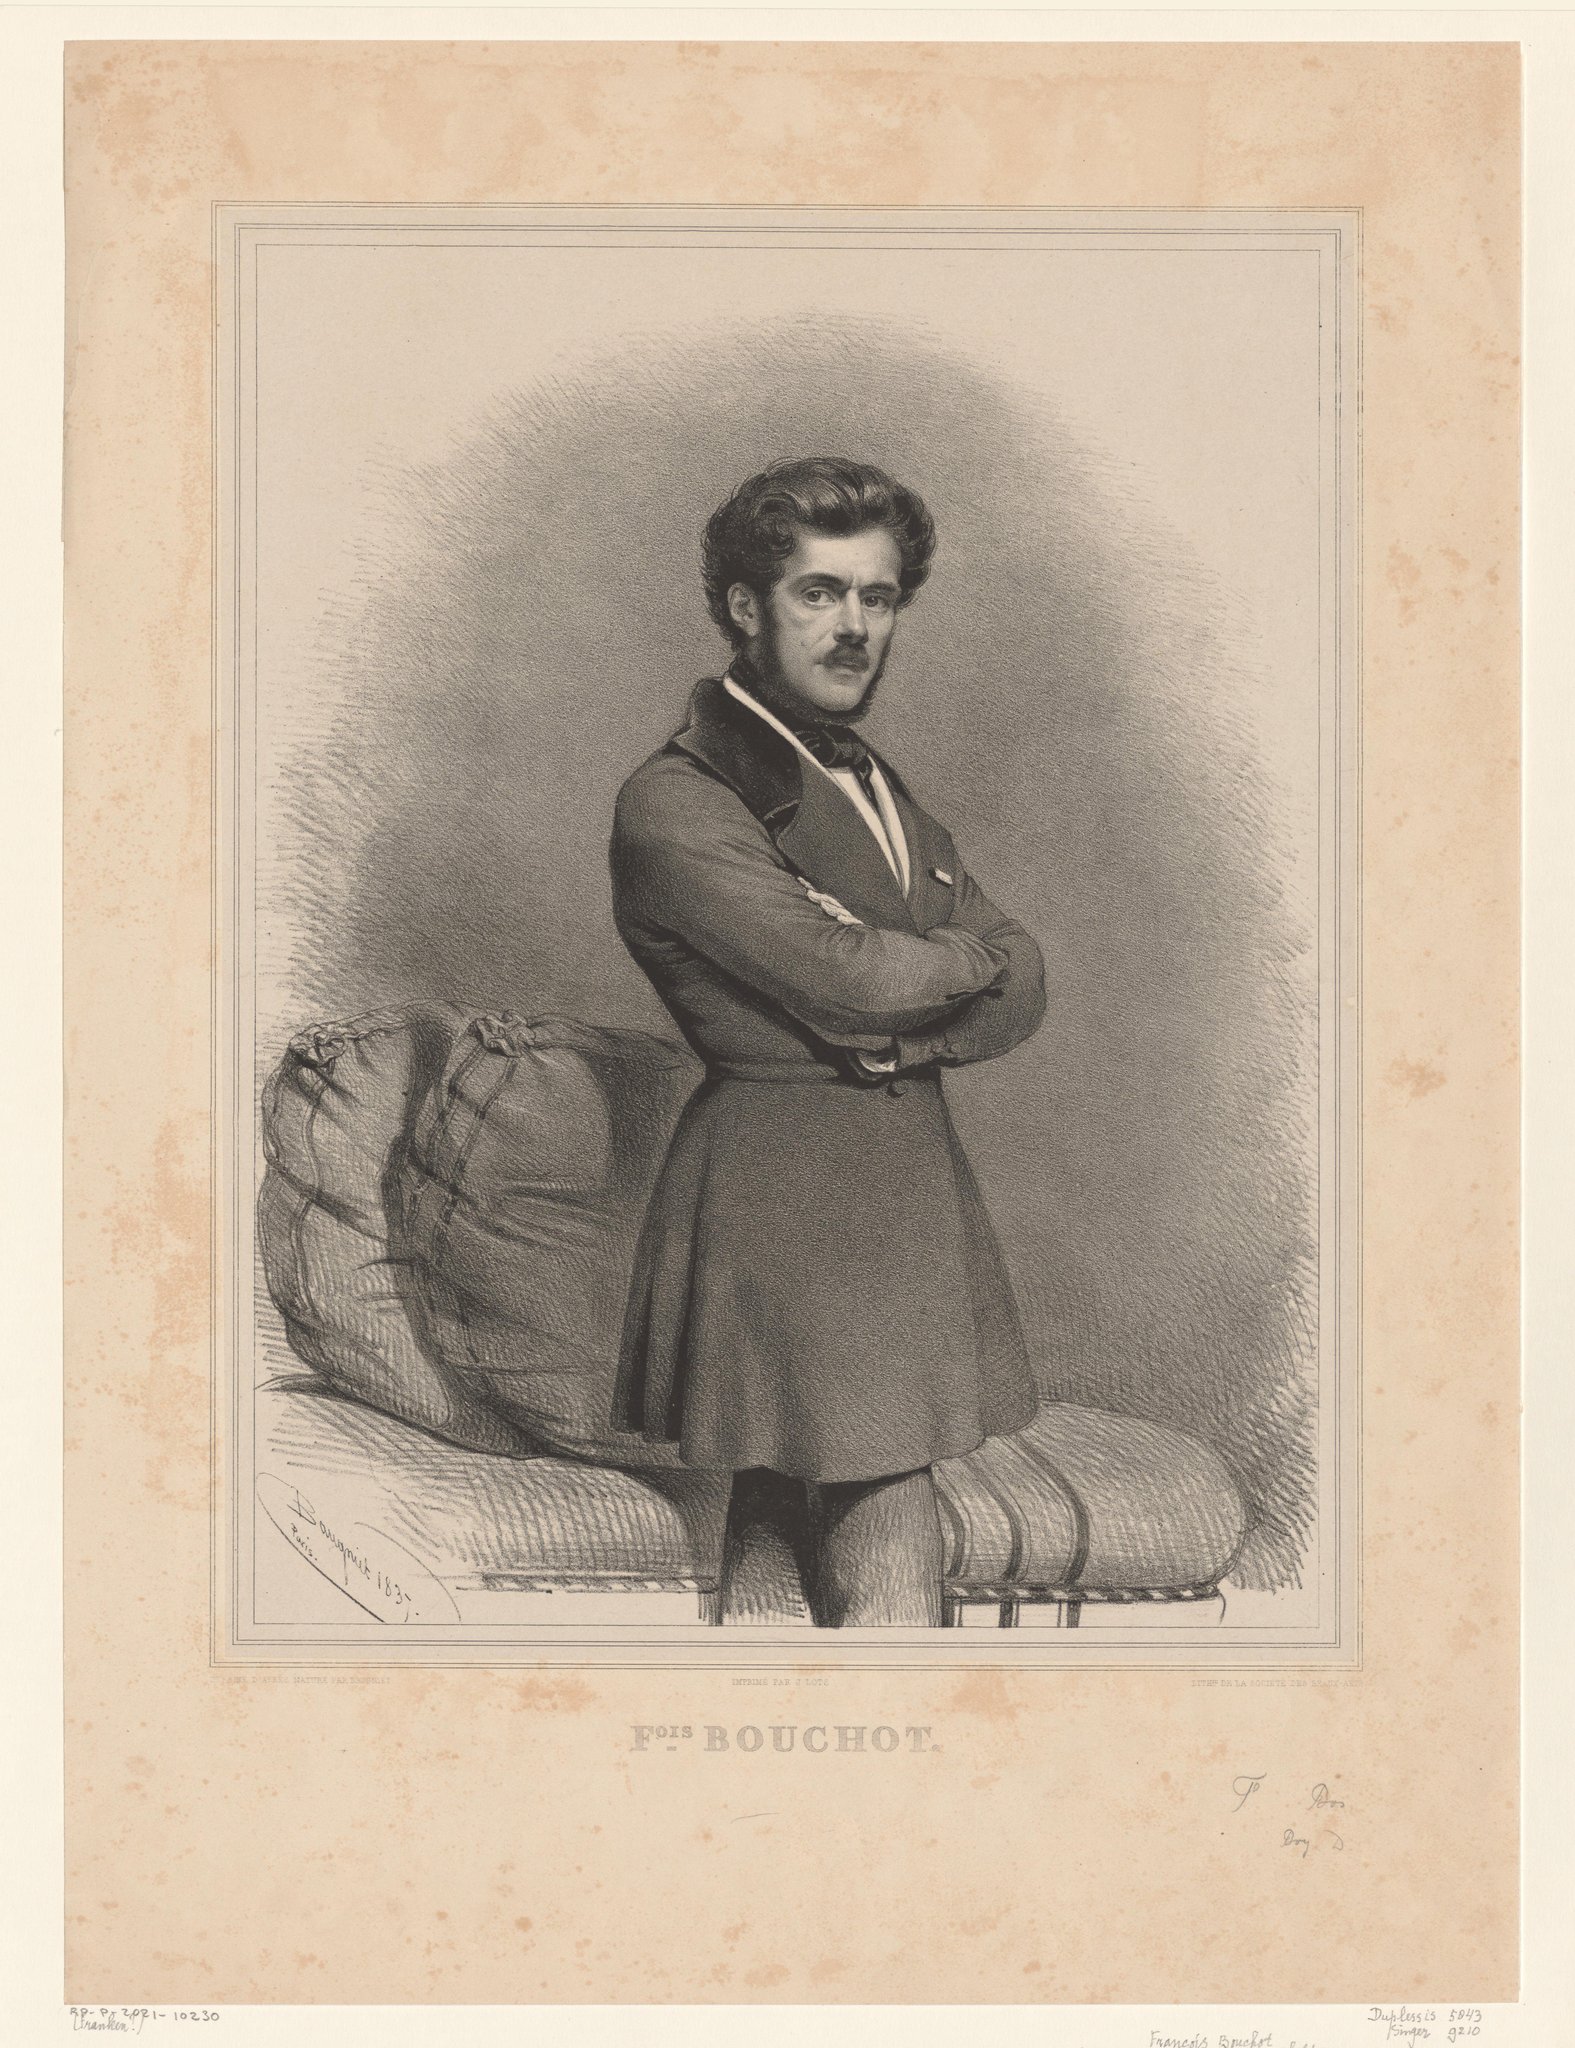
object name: print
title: Portret van François Bouchot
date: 1837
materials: paper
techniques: lithograph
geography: brussels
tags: paris, painter, françois bouchot, arms crossed, adult man, historical persons, pillow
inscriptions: collector's mark: Lugt 2228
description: Andere staat gebruikt in: Baugniet, Charles. Les artistes contemporains: portraits lithographiés d'après nature, accompagnés de notices sur la vie et les ouvrages de chacun d'eux. Brussel: De Wasme-Pletinckx, 1836-1840.